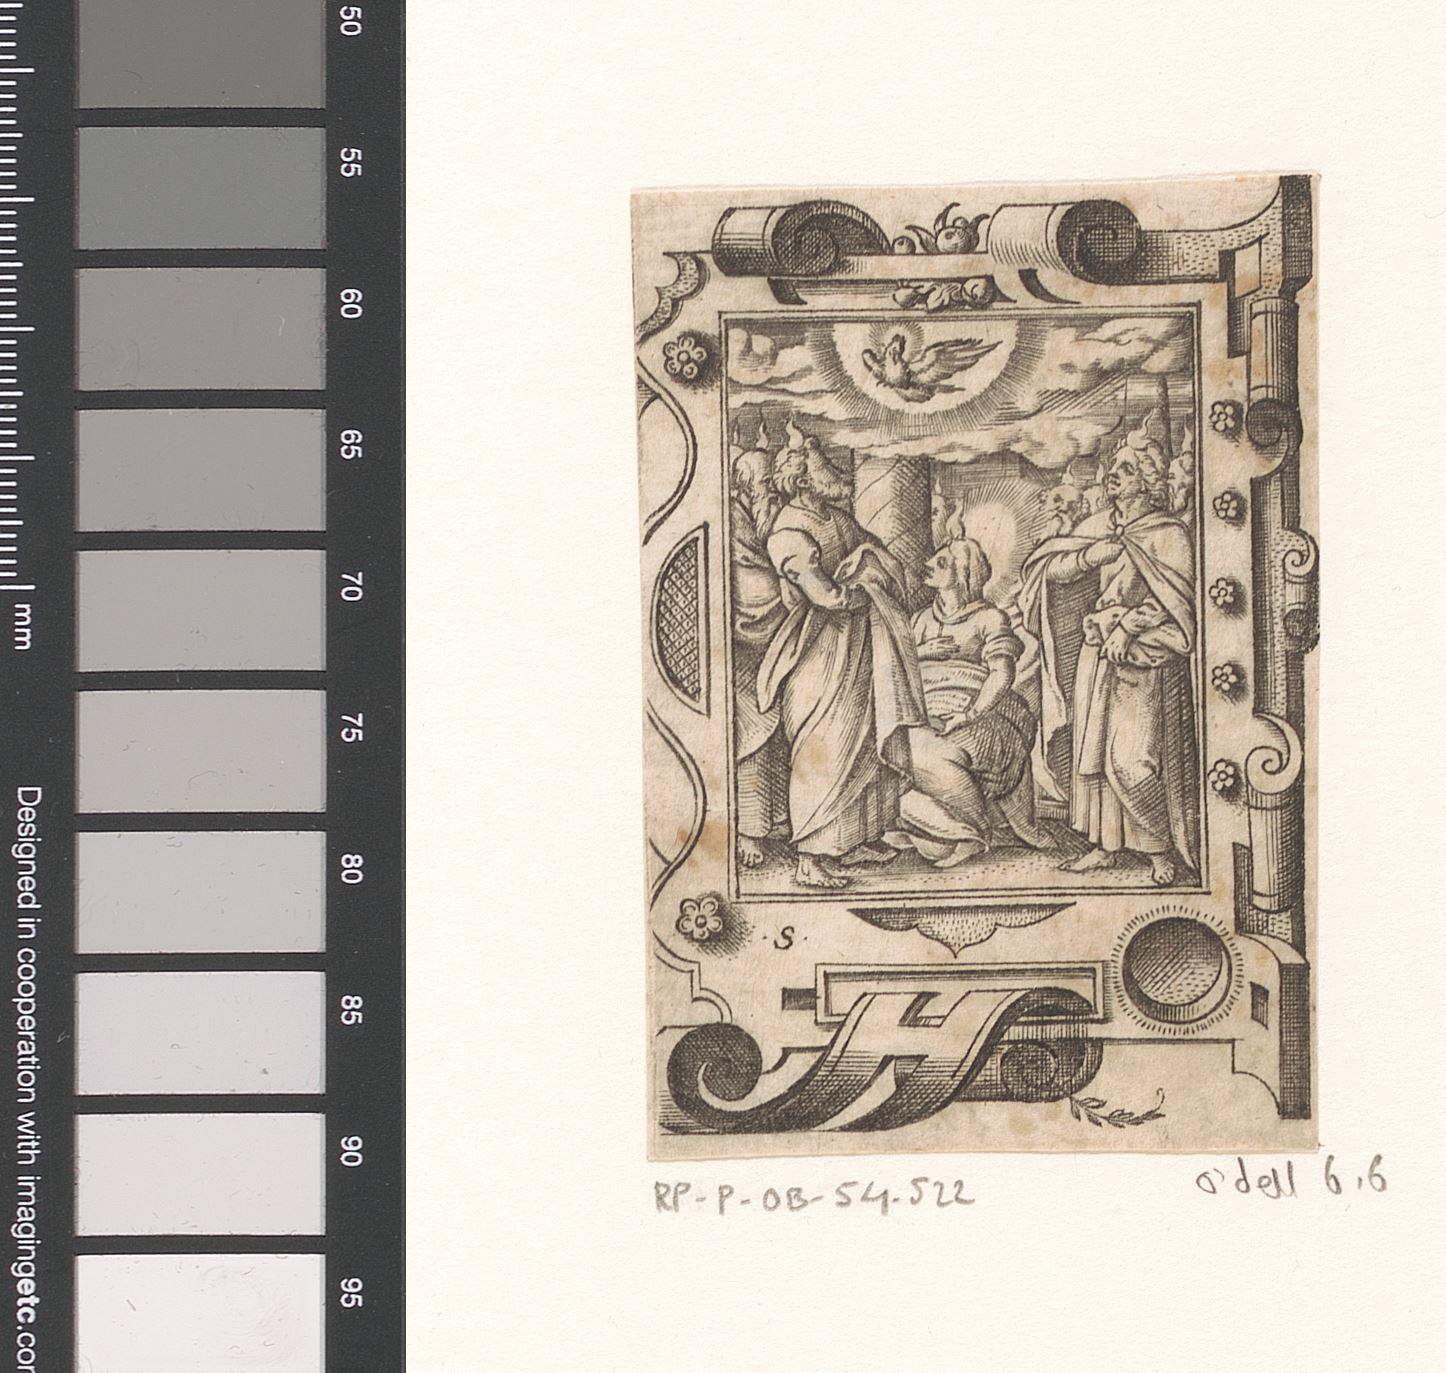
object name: print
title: Uitstorting van de Heilige Geest in een rolwerk omlijsting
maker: virgilius solis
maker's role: draughtsman, print maker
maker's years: 1514-1562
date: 1568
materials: paper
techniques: engraving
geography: nuremberg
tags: scrollwork, strapwork ~ ornament, pentecost: the holy ghost descends upon (mary and) the apostles, sometimes paul and/or representatives of the nations present (acts 2:1-4)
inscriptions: number: ‘86’, collector's mark: Lugt 2228, collector's mark: Lugt 240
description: Prent gebruikt voor het gebedenboek: Solis, Virgil. Ein New Künstlich Betbüchlein. Neurenberg: Hieronymus Petri, 1568. Bij elke prent met een Bijbelse scène behoort een genummerde prent met een gebed in het Latijn en in het Duits. Het monogram VS is steeds verspreid over twee bij elkaar horende prenten.